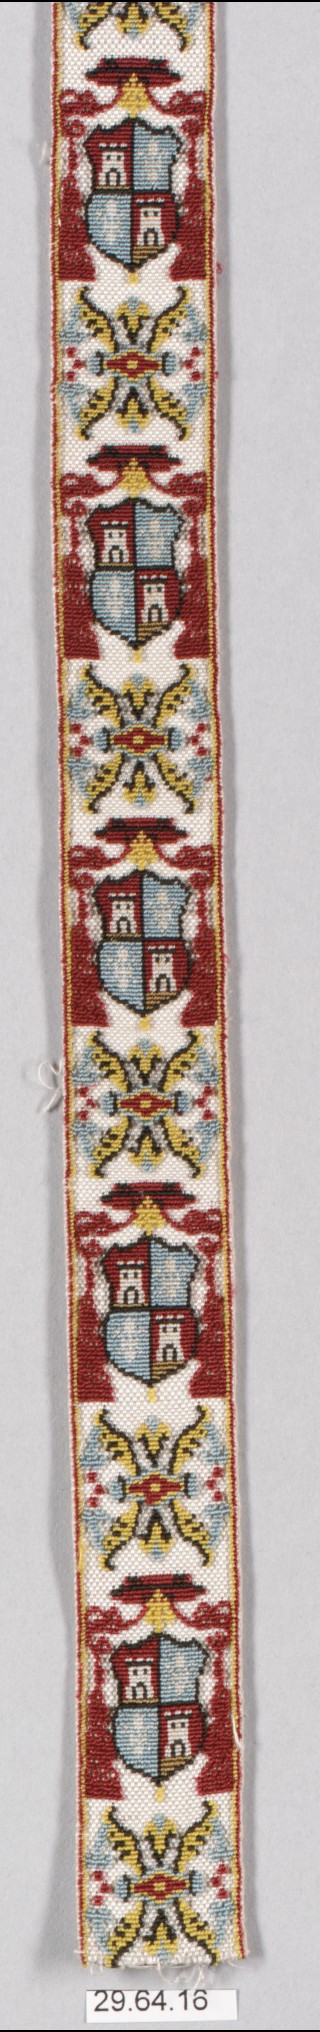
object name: galloon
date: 1701-1900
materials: silk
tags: coat of arms